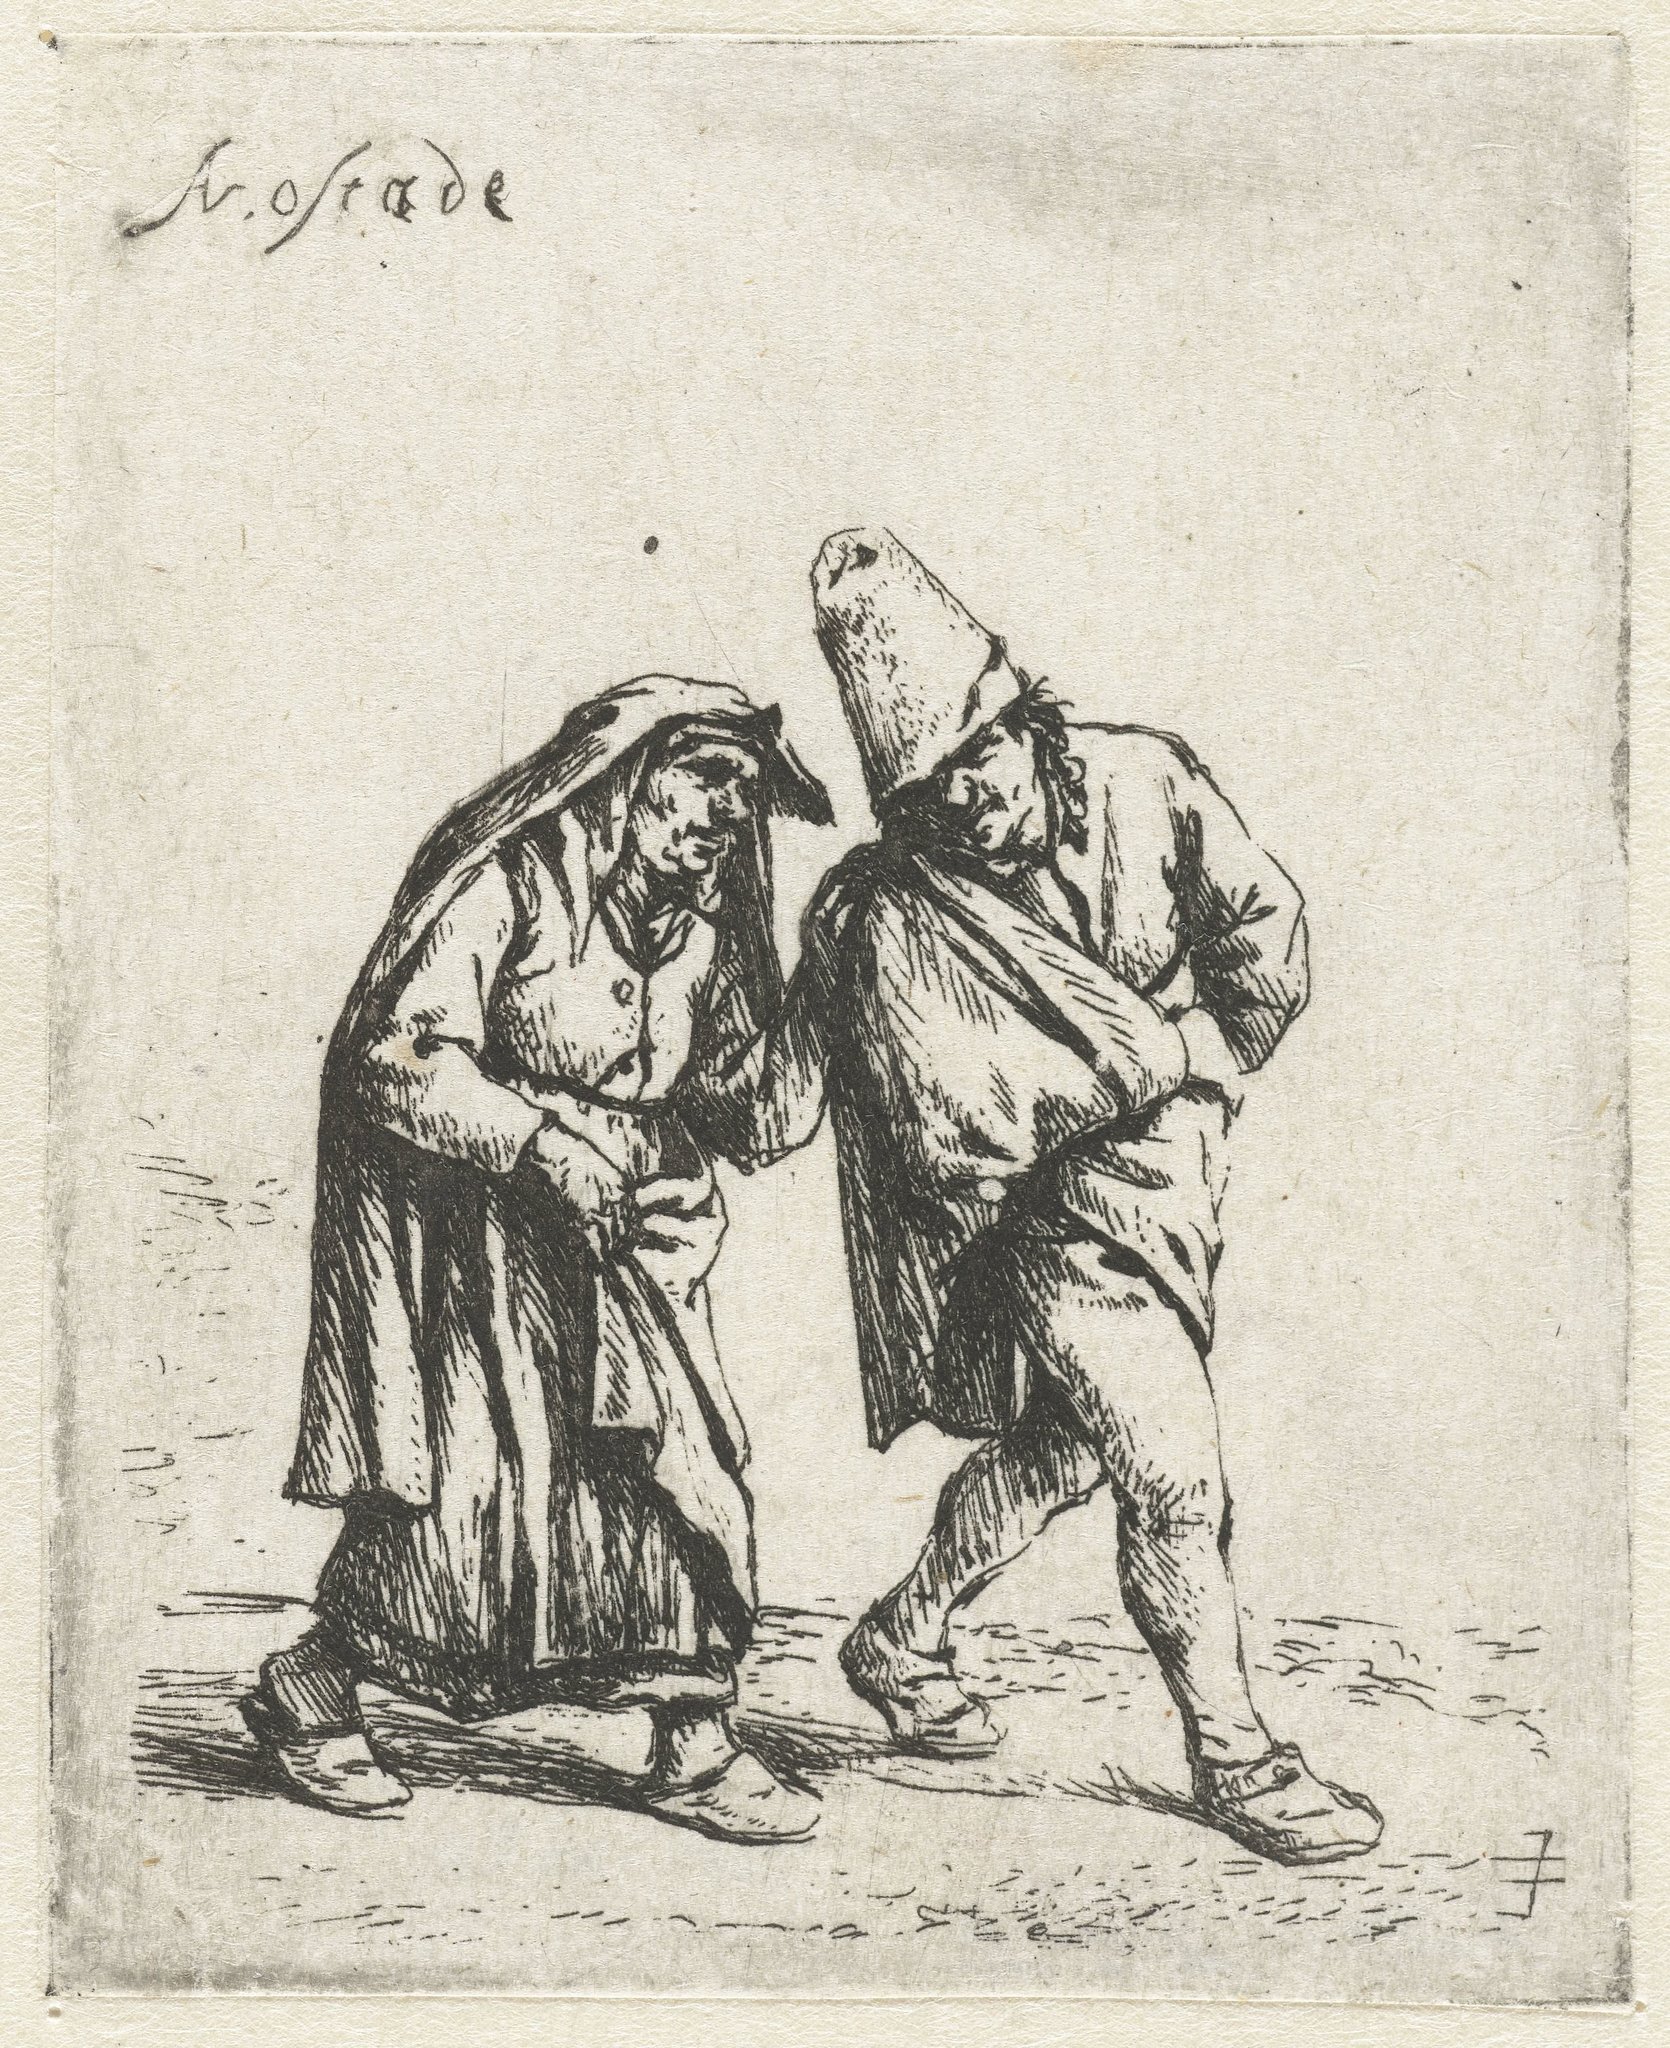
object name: print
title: Wandelend boerenpaar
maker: adriaen van ostade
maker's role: draughtsman, painter, print maker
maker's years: 1610-1685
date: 1646-1649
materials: paper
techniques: etching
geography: haarlem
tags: farmers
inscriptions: collector's mark: Lugt 240